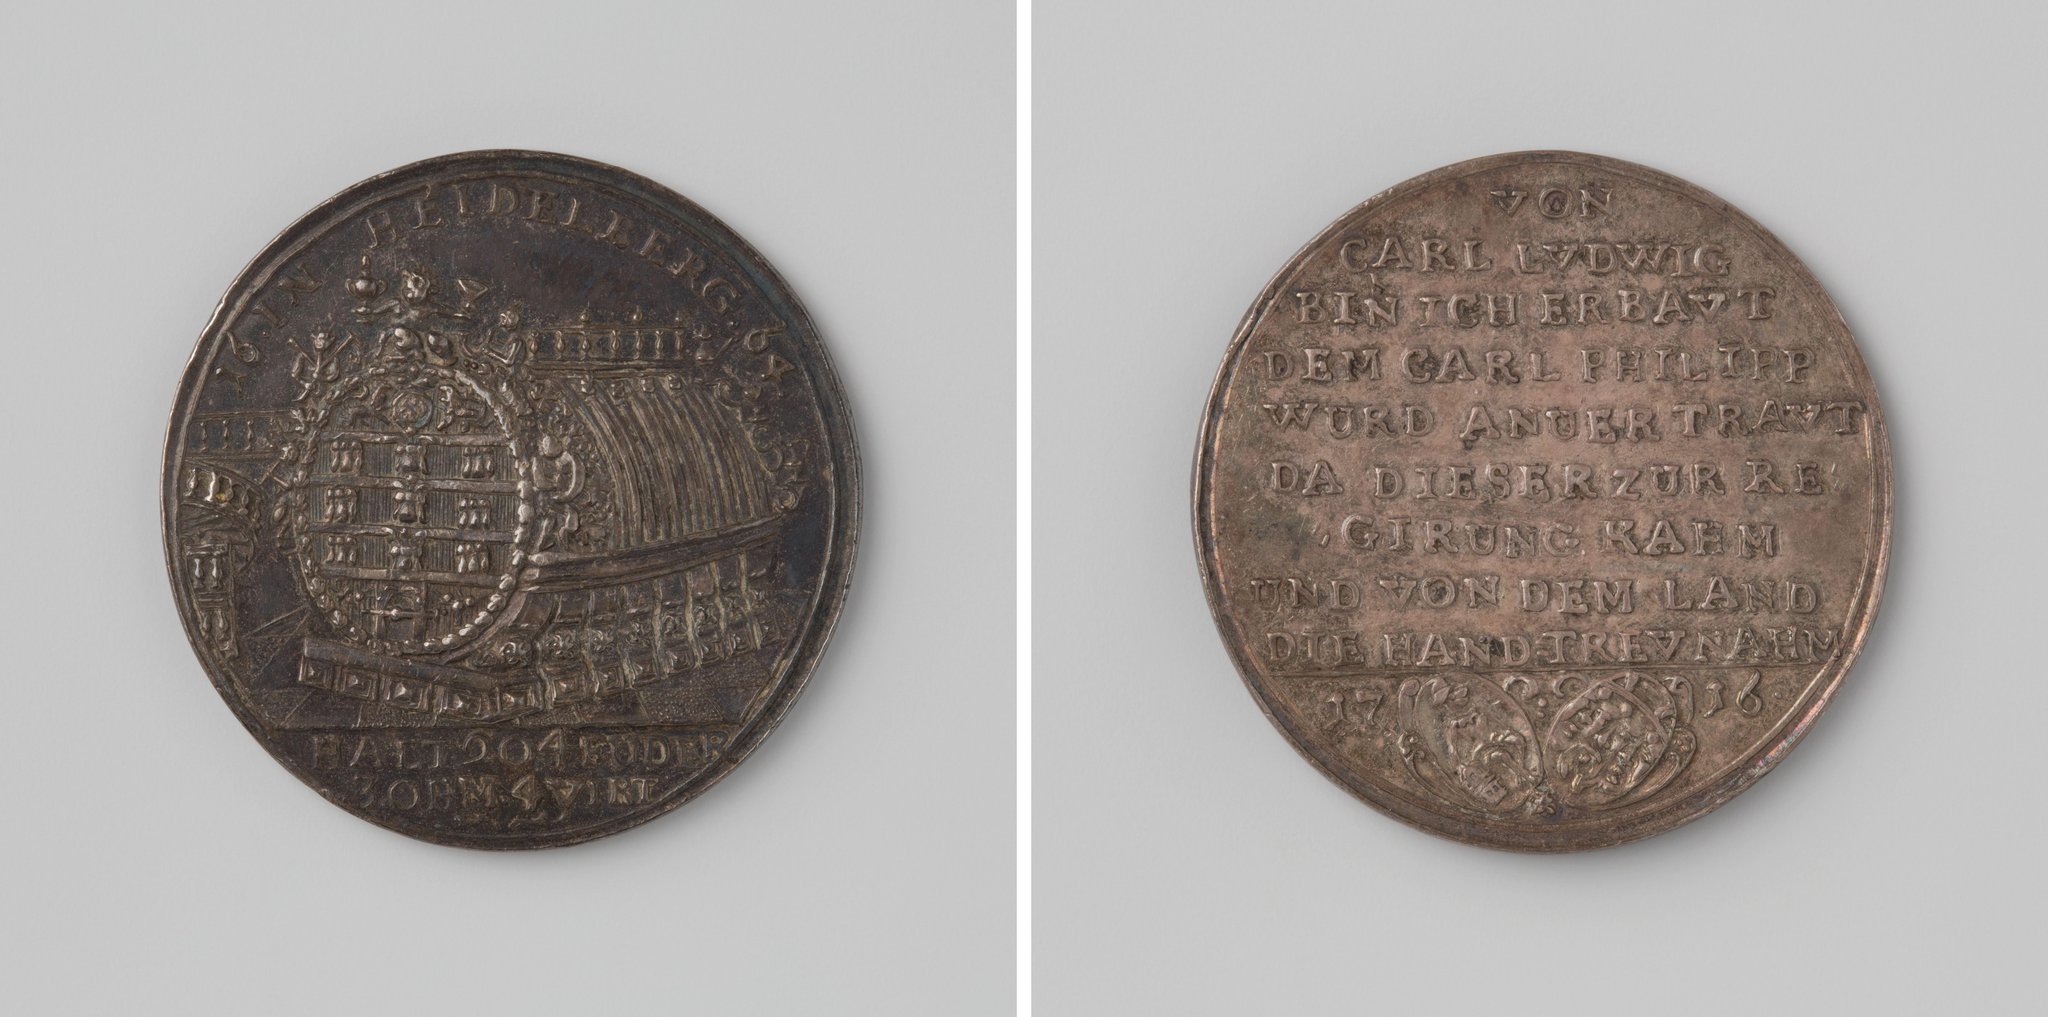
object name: history medal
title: Reparatie van het Heidelberger wijnvat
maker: Anonymous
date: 1716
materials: silver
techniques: striking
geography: germany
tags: edingen, keurvorst, keurvorst van de palts karel lodewijk, heidelberg